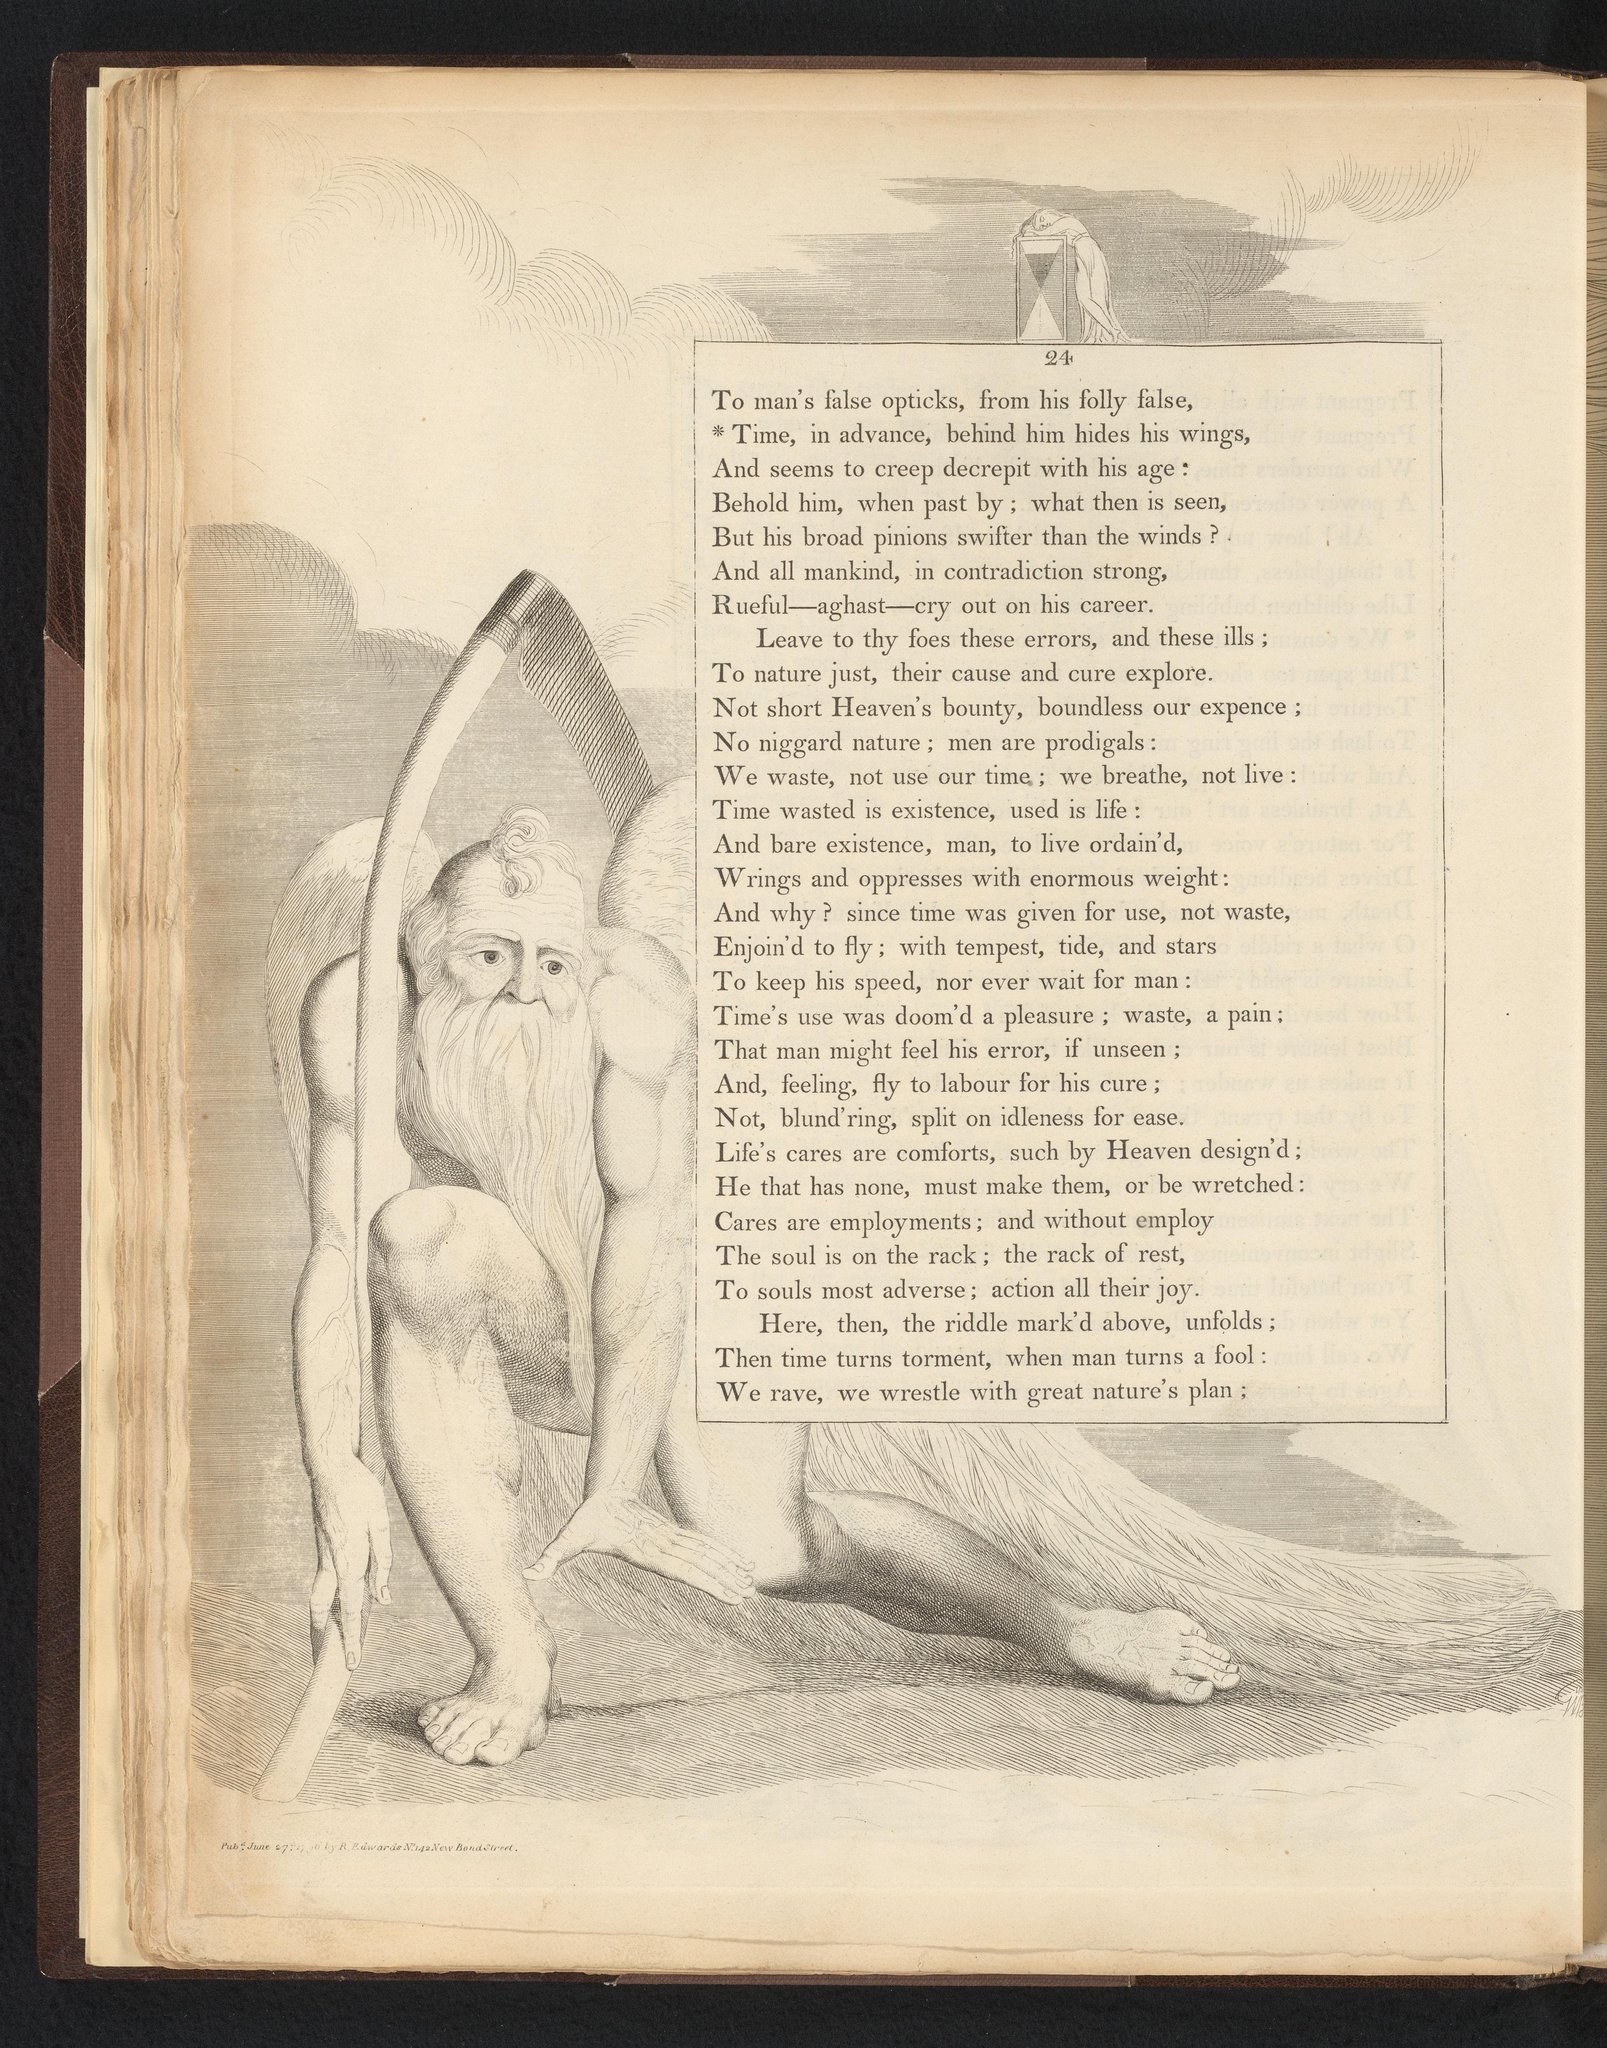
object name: print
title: Vadertje Tijd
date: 1796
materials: paper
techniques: engraving, letterpress printing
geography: london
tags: father time, man with wings and scythe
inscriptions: : ‘To man's false opticks, from his folly false, (...)’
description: Prent maakt deel uit van een boek, bladzijde 24. Tekst in het Engels op recto en verso.